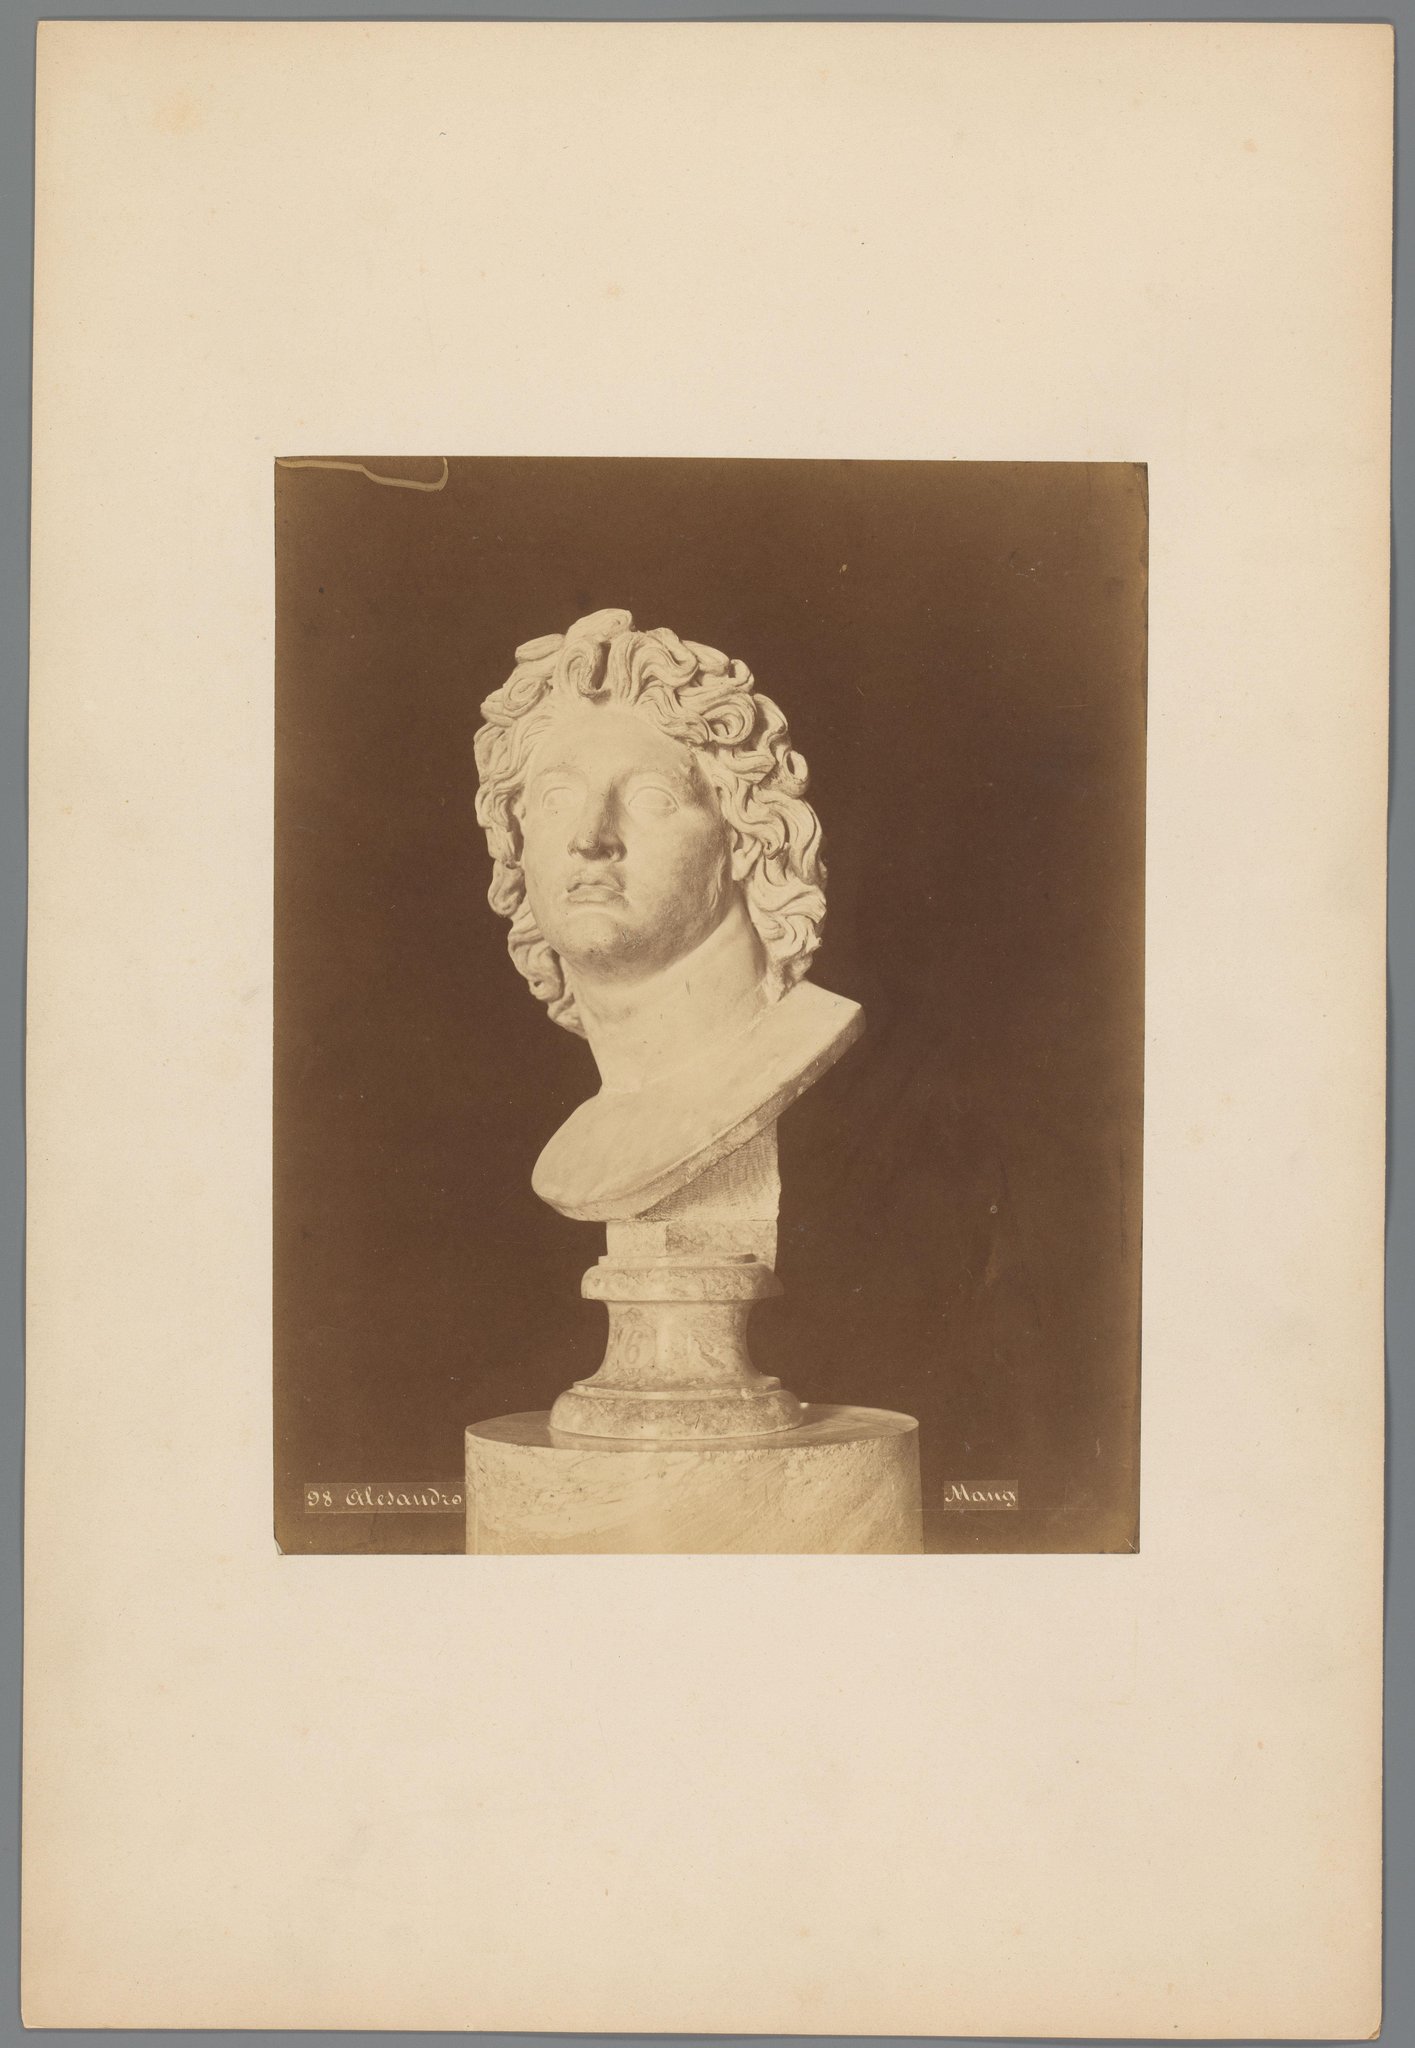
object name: photograph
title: Buste van Alexander de Grote als Helios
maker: michèle mang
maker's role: fotograaf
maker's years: 1840-1909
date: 1863-1887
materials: cardboard, paper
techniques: albumen print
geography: rome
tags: head (human), piece of sculpture, reproduction of a piece of sculpture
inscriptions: number: ‘98’